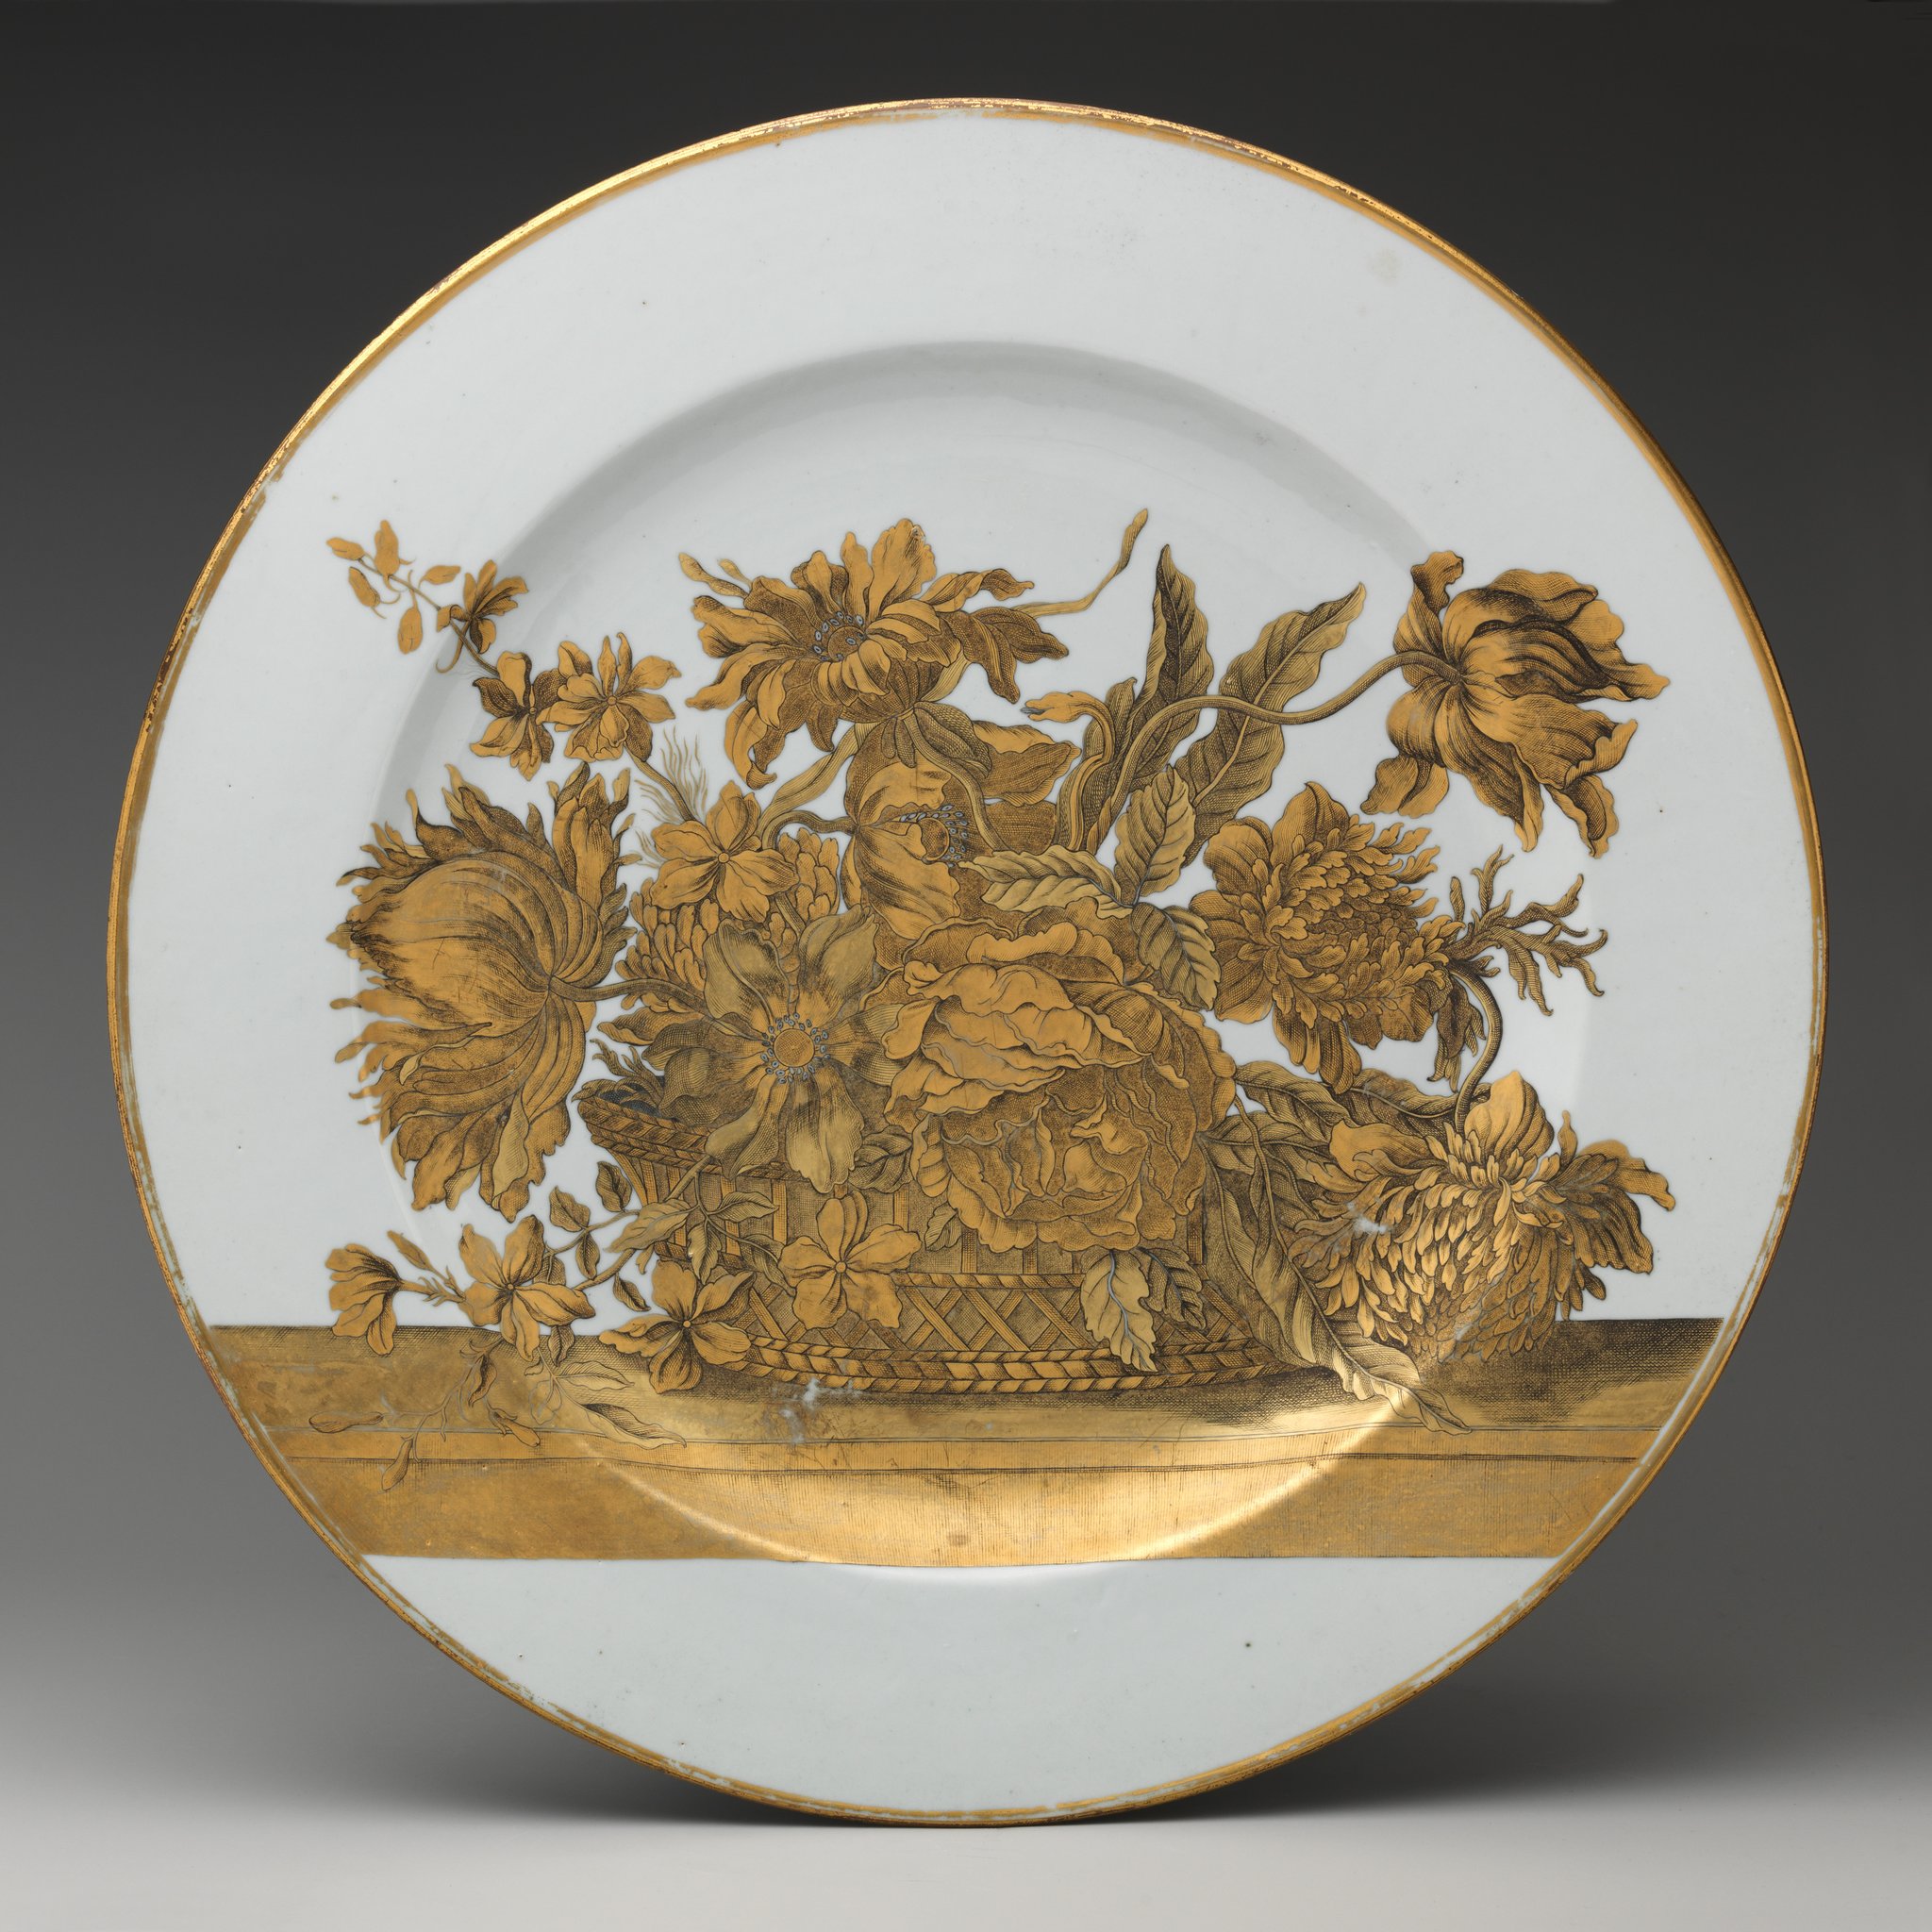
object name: plate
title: Plate (one of a pair)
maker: jean-baptiste monnoyer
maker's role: artist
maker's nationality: french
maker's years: 1636-1699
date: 1735-1740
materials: hard paste porcelain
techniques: gilding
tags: flowers